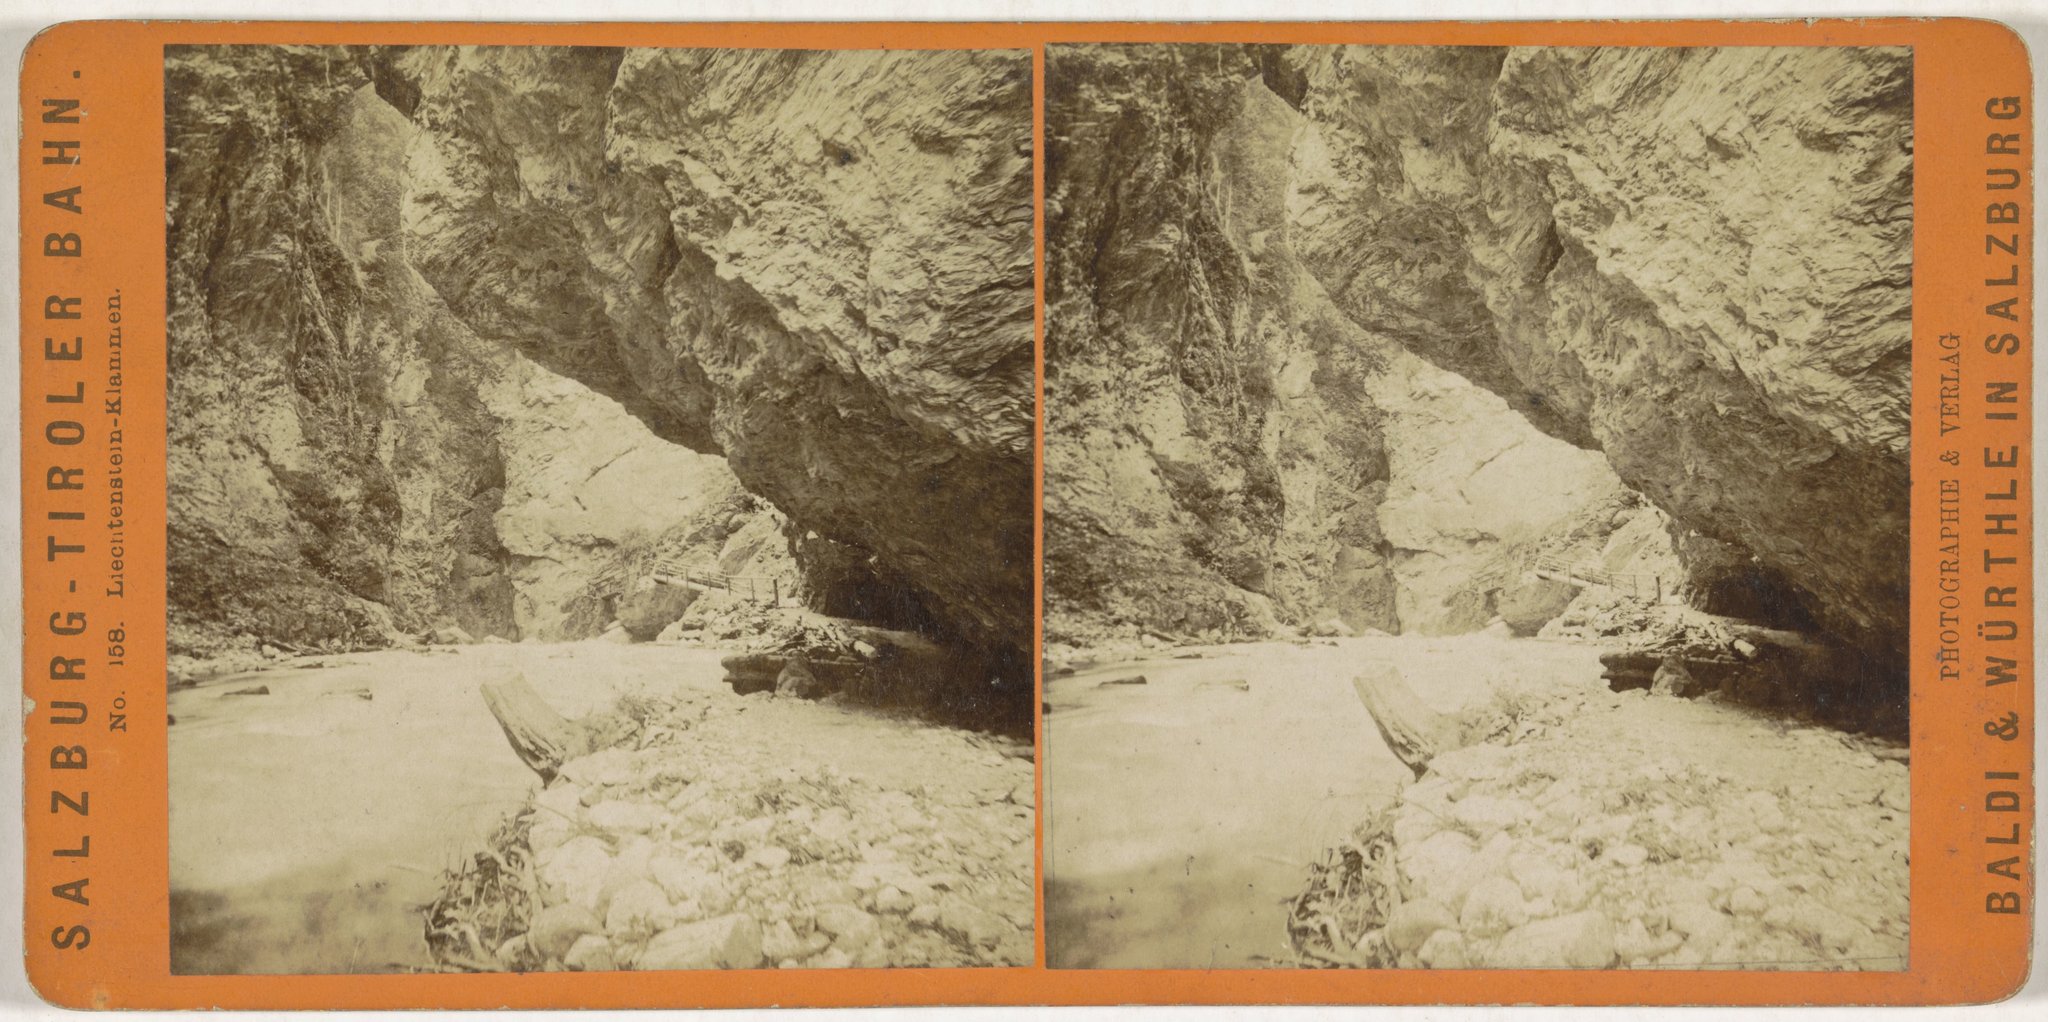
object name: stereograph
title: Salzburg-Tiroler Bahn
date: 1881-1892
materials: cardboard, paper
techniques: albumen print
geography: liechtensteinklamm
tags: brook, rock-formations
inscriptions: number: ‘No. 158’